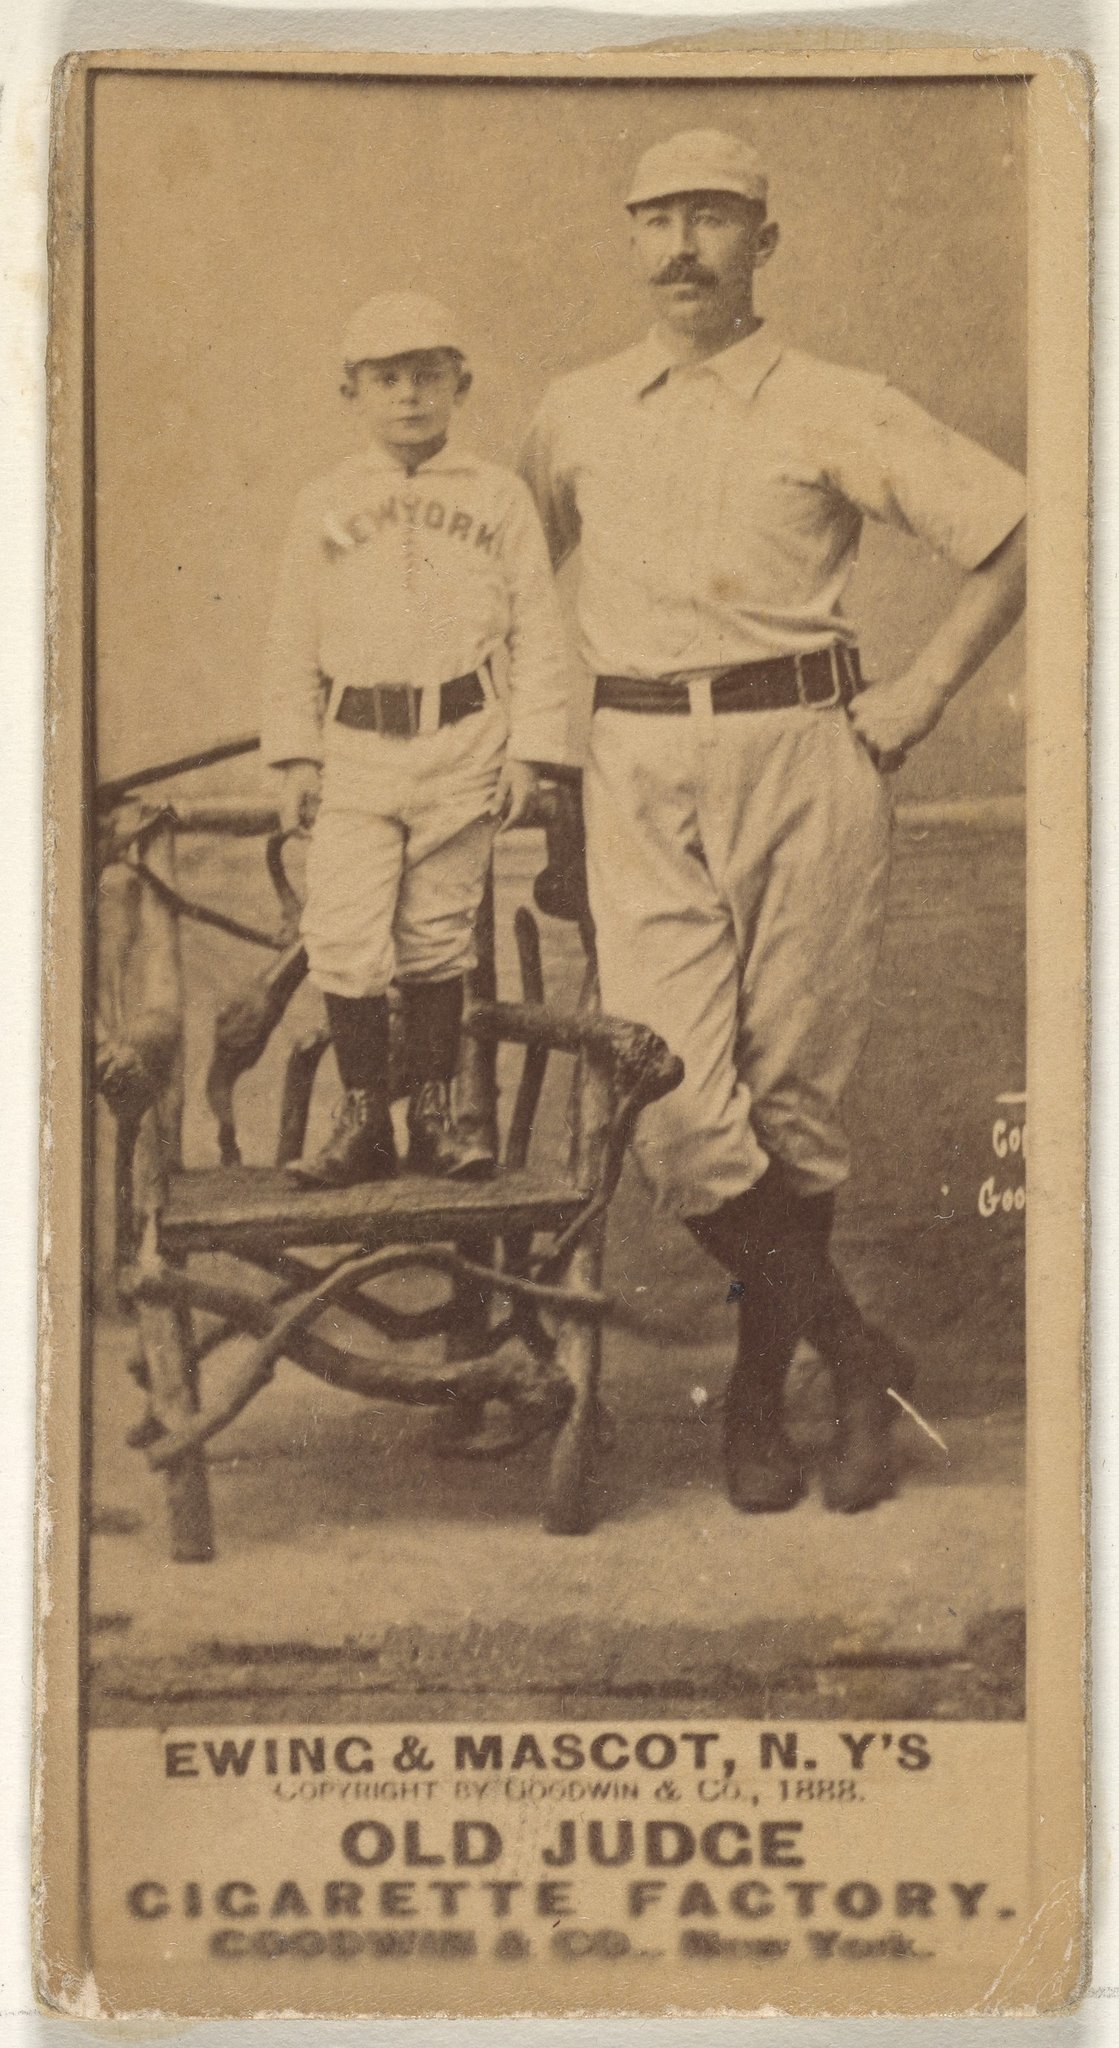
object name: baseball card, photograph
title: William "Buck" Ewing, Captain and Catcher, with Mascot, New York, from the Old Judge series (N172) for Old Judge Cigarettes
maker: goodwin & company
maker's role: publisher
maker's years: 1850-1950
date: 1888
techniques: albumen silver print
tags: boys,men,portraits,baseball,athletes,chairs